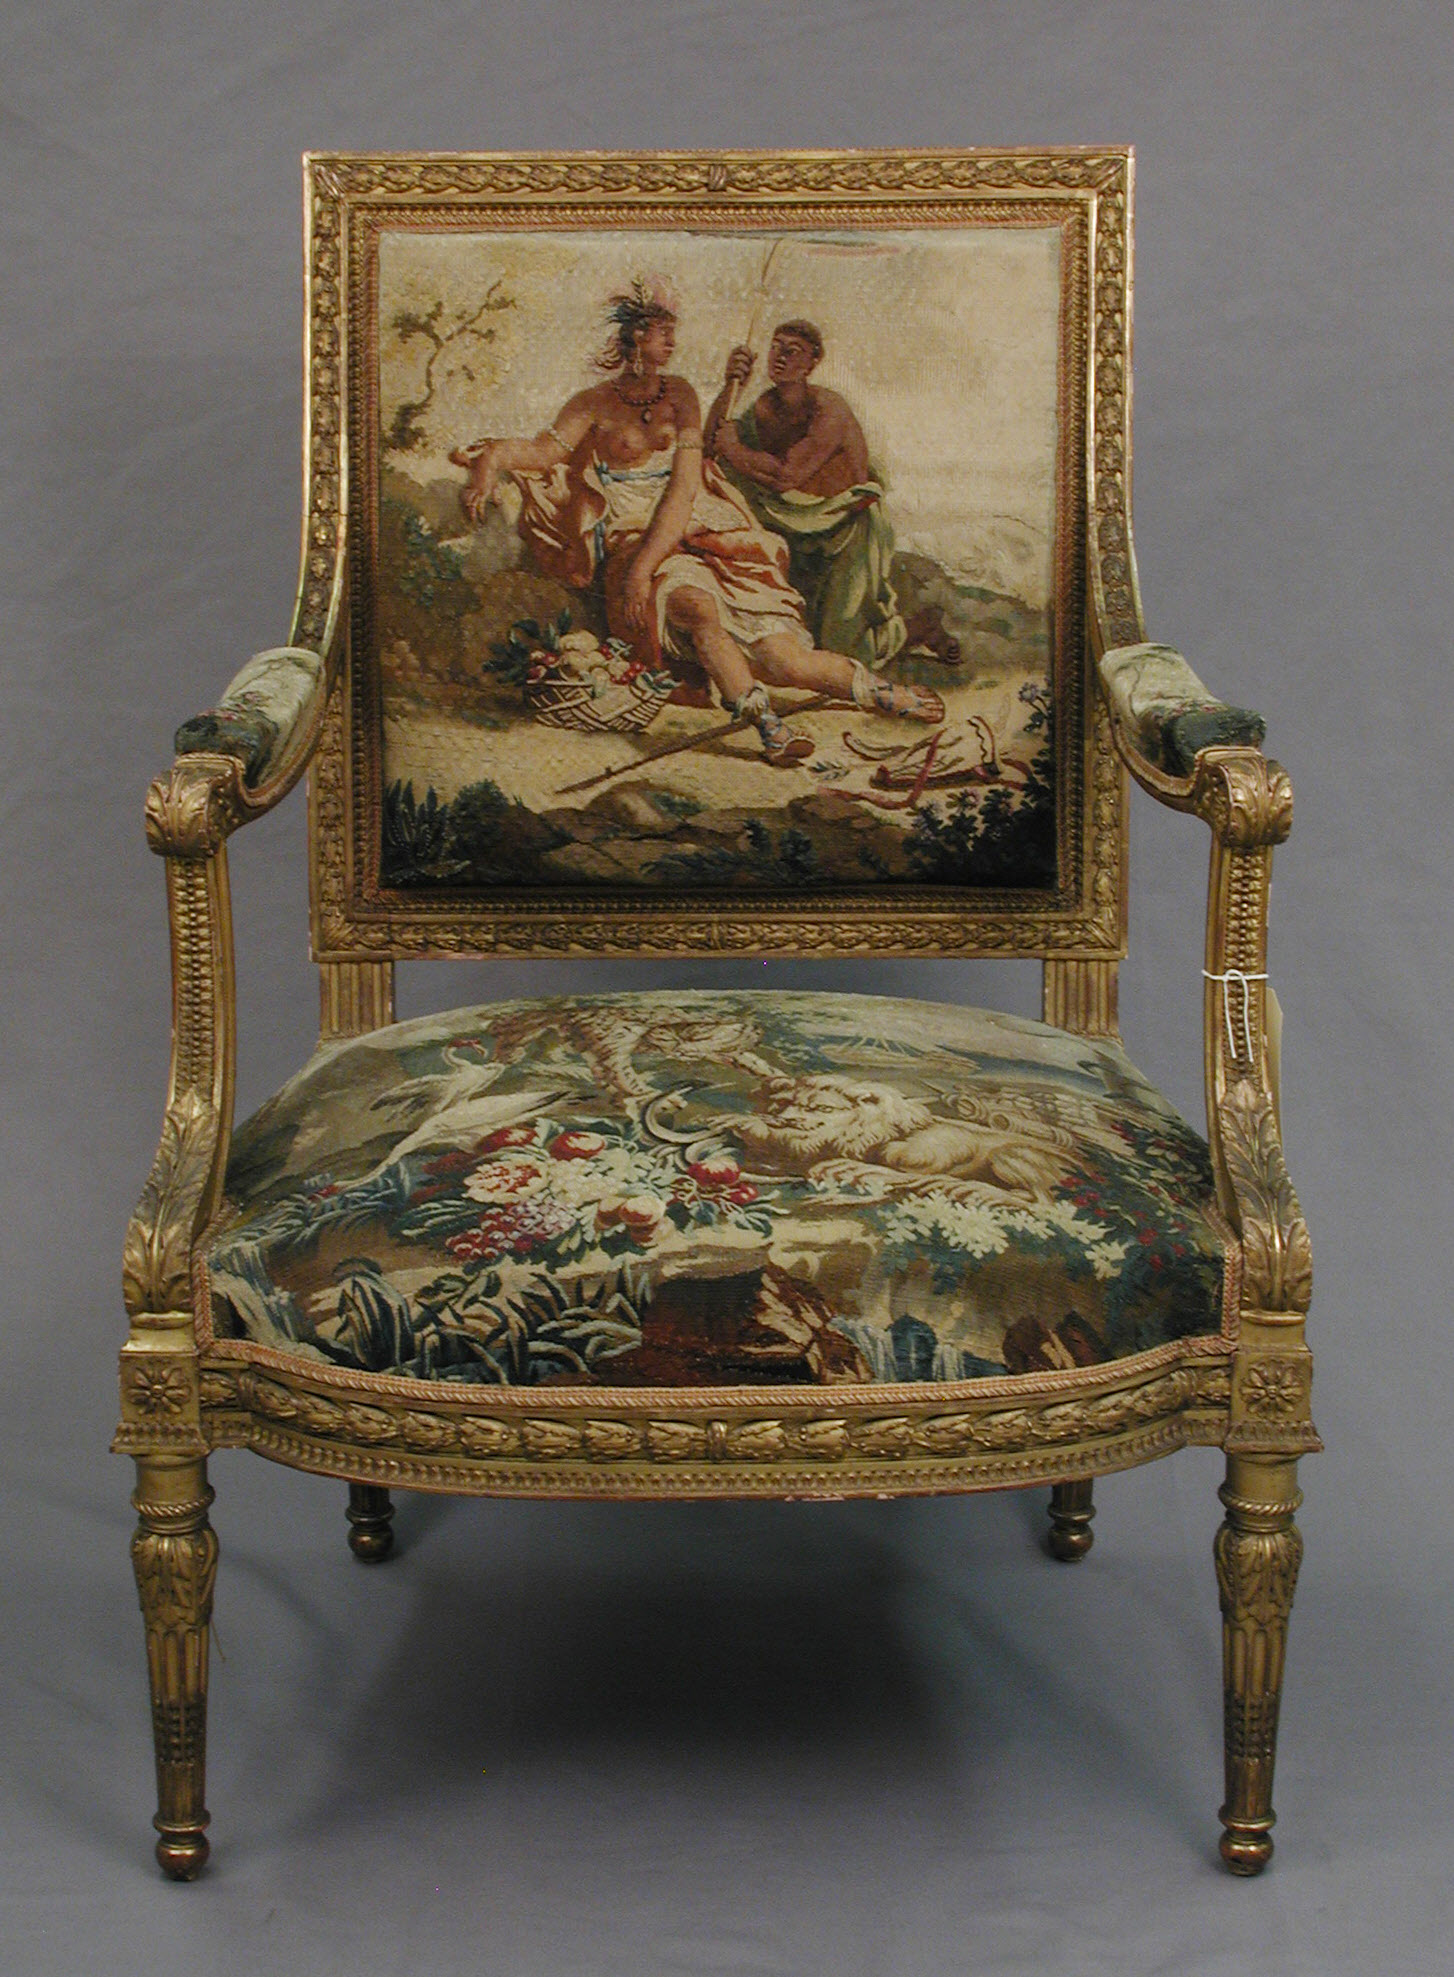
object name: armchair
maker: beauvais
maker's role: manufactory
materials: silk, wood, wool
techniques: carving, gilding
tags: birds,men,female nudes,lions